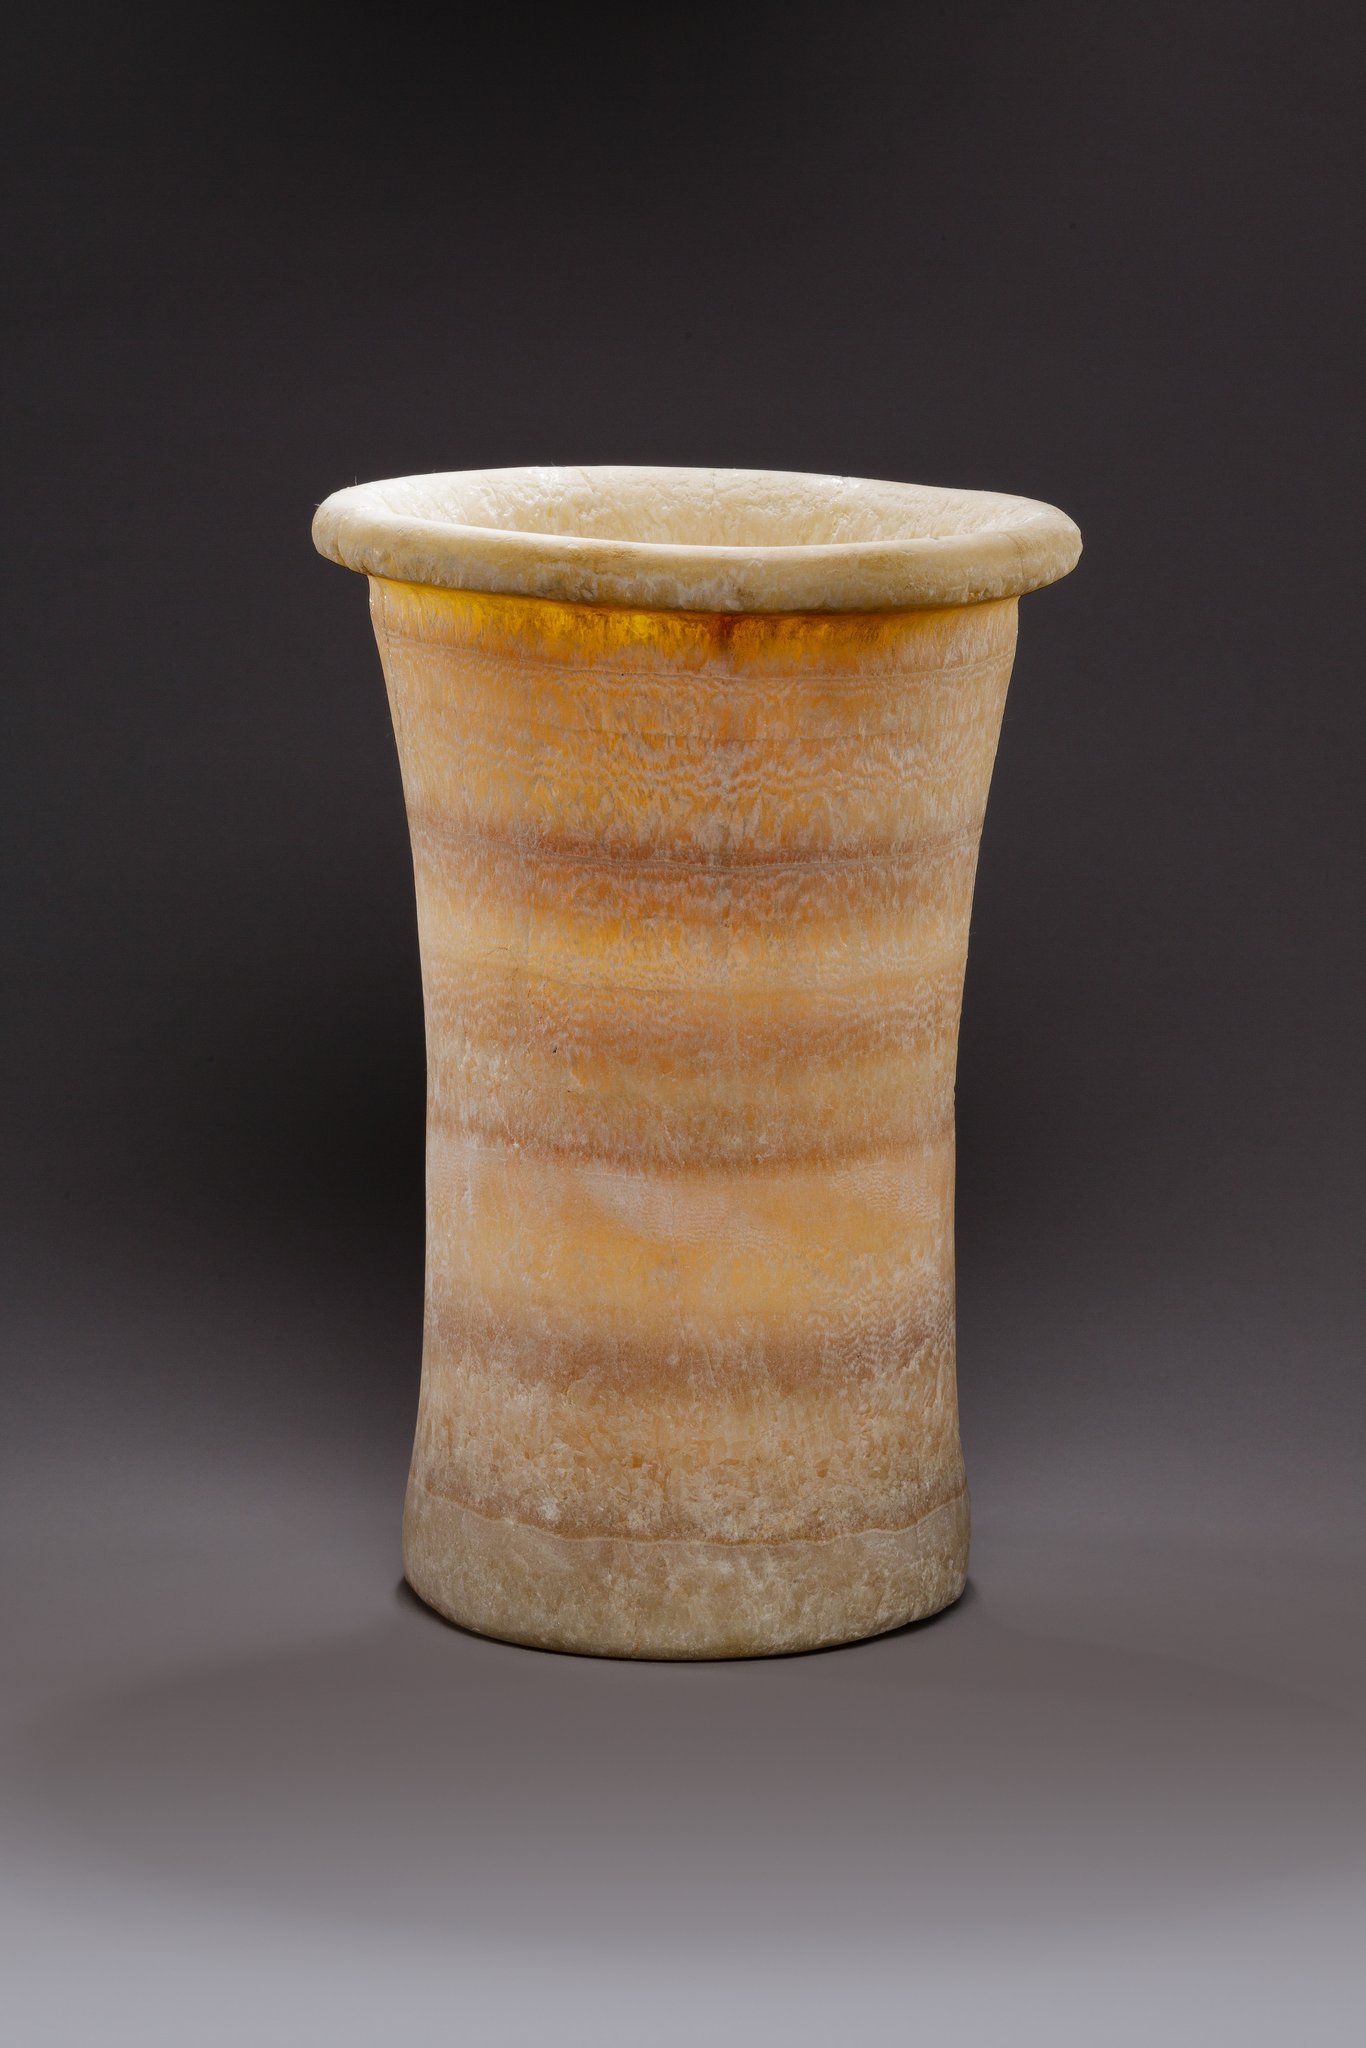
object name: jar, cylindrical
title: Cylindrical jar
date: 2750-2649 BCE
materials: stone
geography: egypt